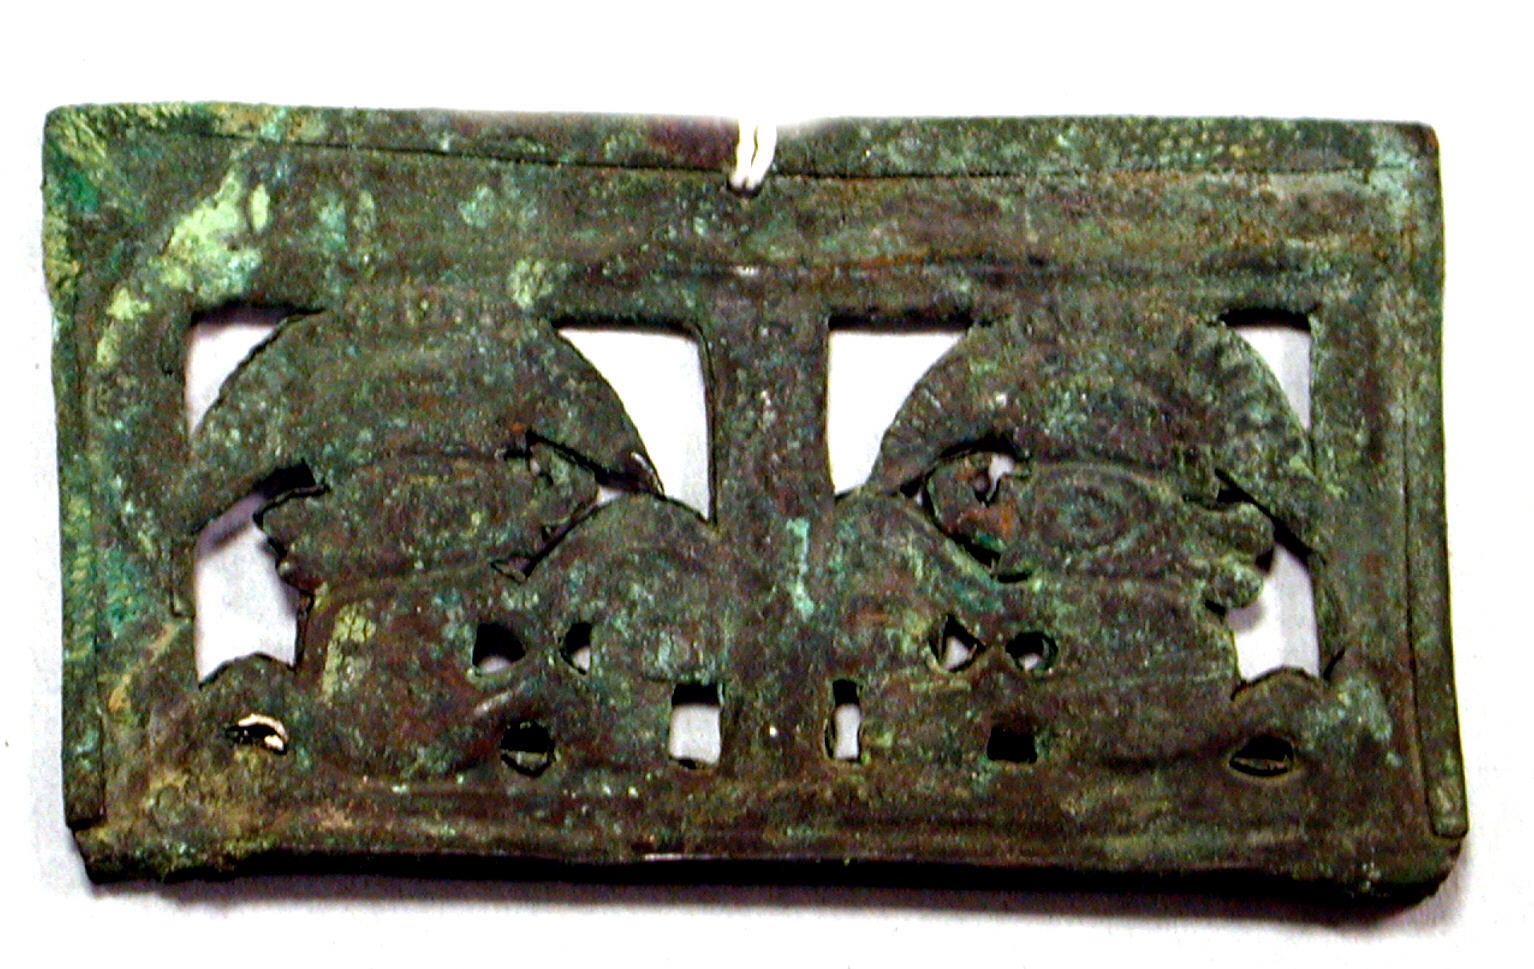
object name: scale balance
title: Copper Scale Balance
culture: chimú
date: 1101-1500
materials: copper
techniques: hammering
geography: peru